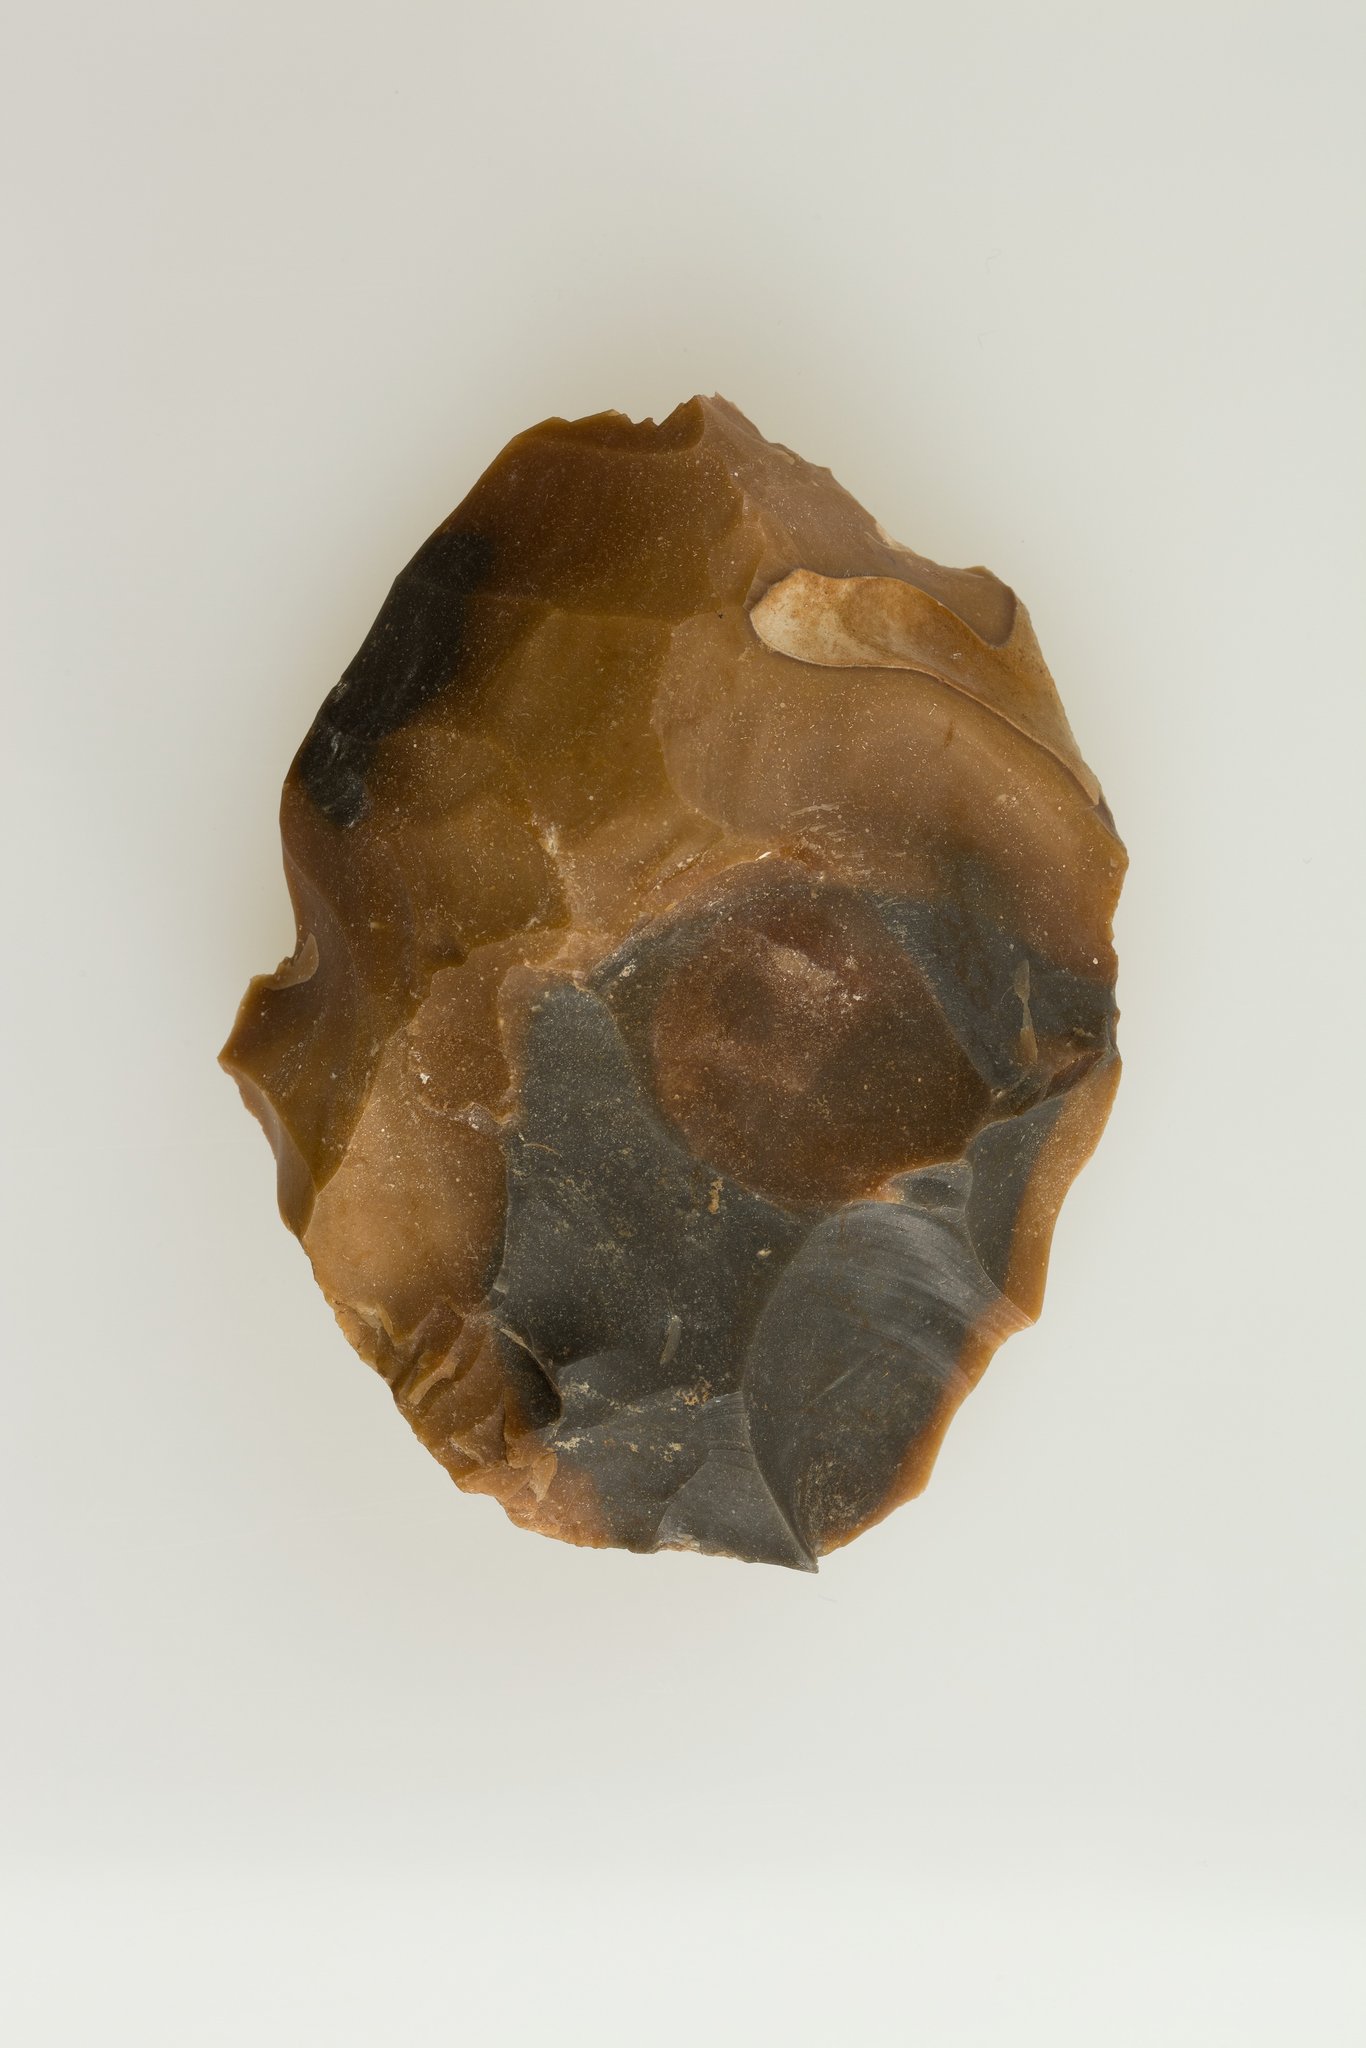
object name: core, discoidal, opposite platform, opposed platform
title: Core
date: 4000-3800 BCE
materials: stone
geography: egypt